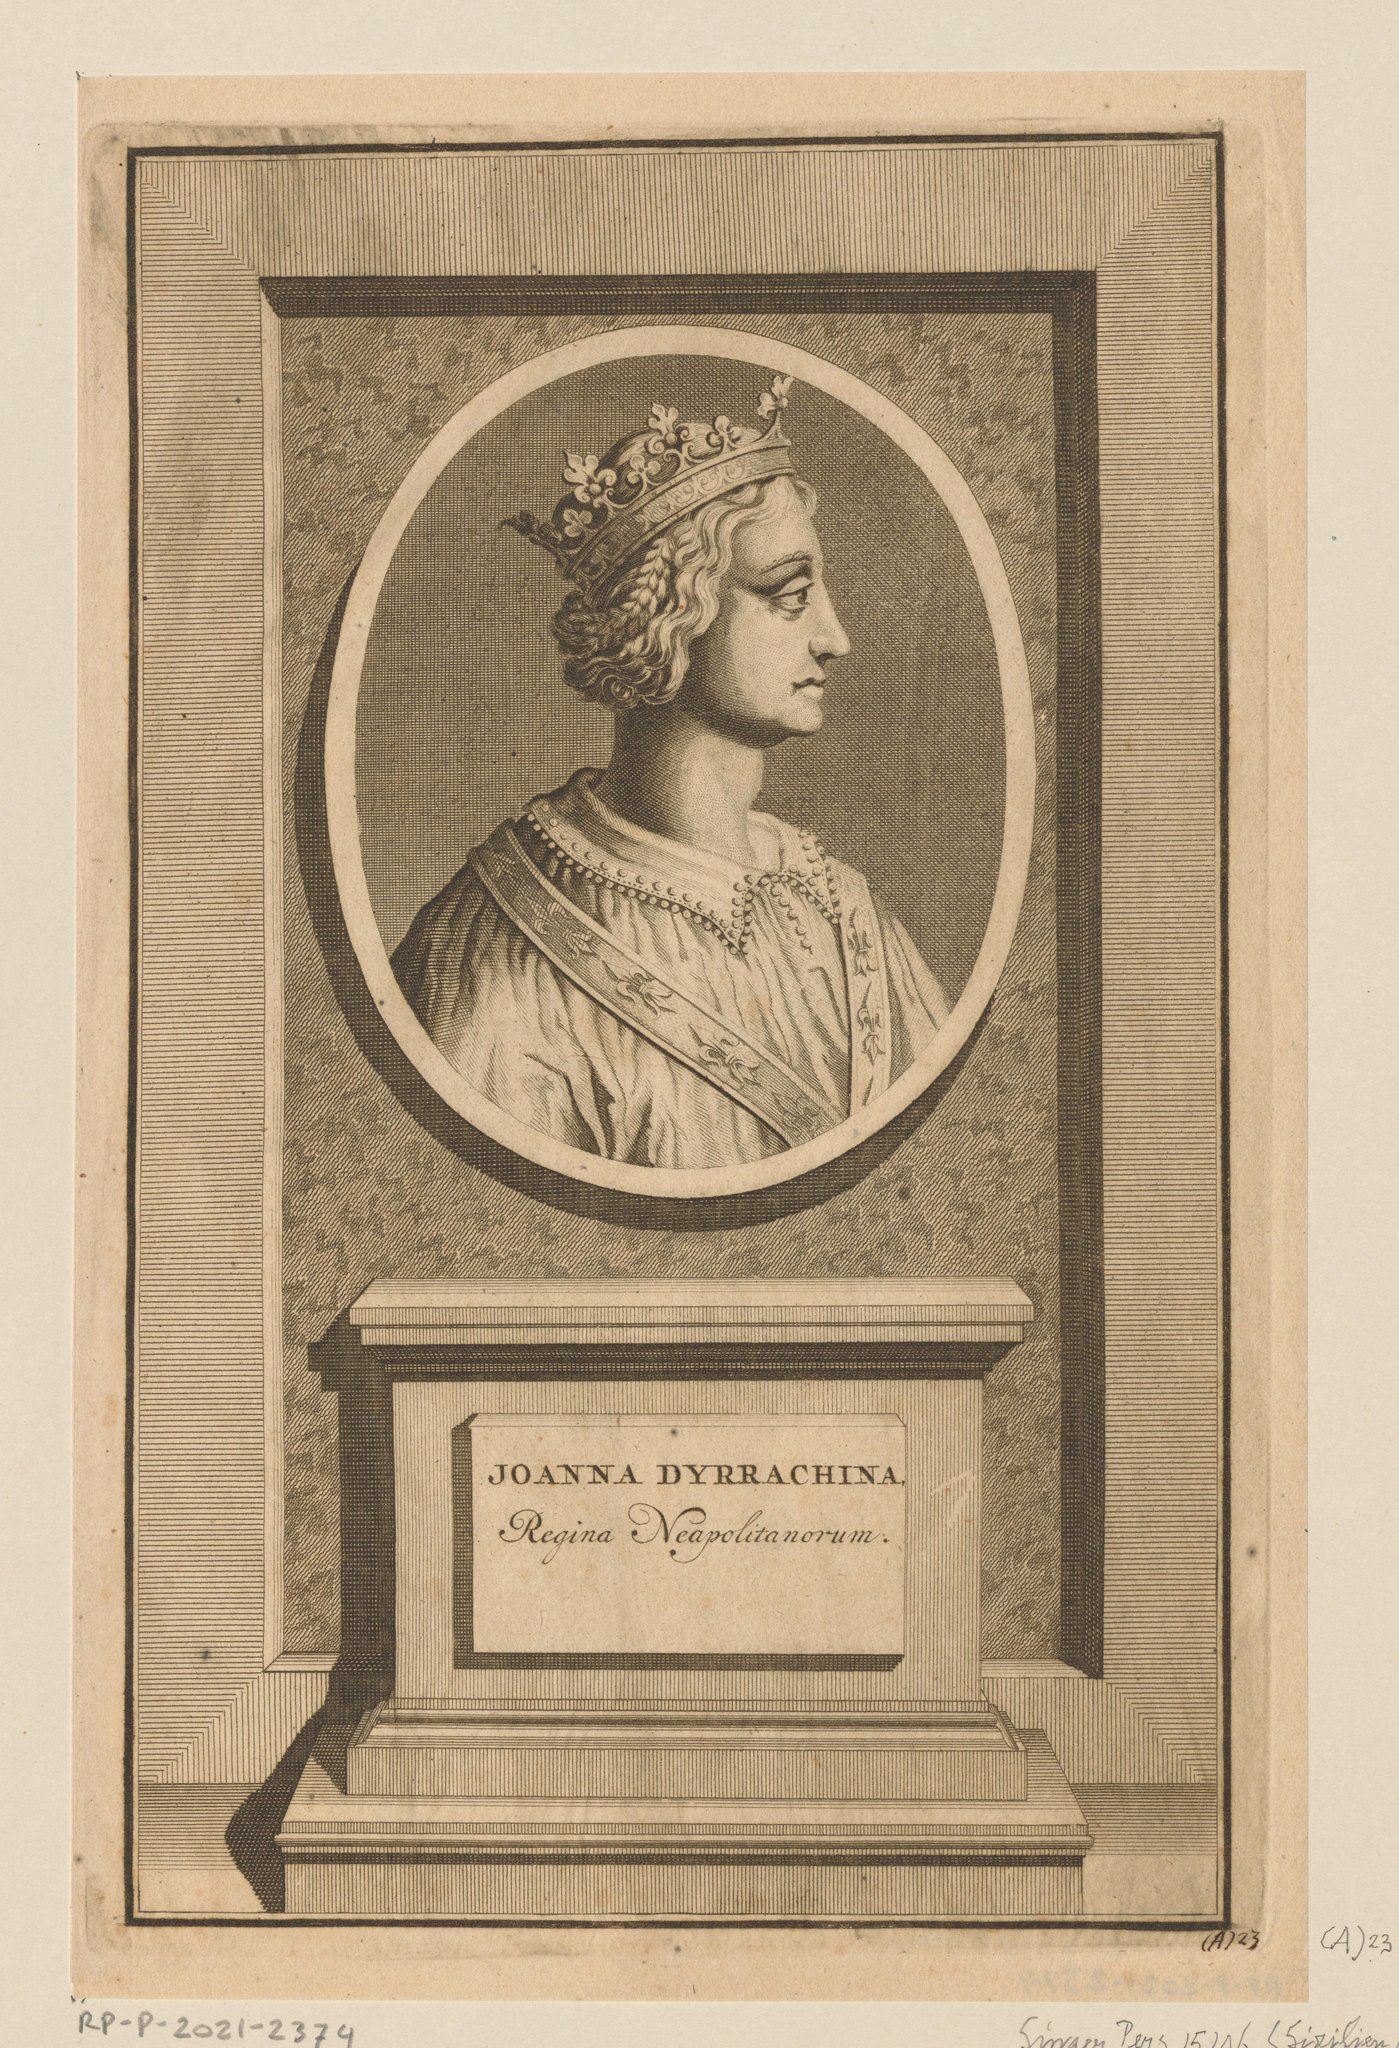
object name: print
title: Portret van Johanna II van Napels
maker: Anonymous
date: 1723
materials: paper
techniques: engraving, etching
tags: naples, historical persons - bb - woman, queen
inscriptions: inscription: ‘(A)23’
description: Prent mogelijk uit: Graevius, Johann Georg. Thesaurus antiquitatum et historiarum Italiae (...). Leiden: Pieter van der Aa, 1723.